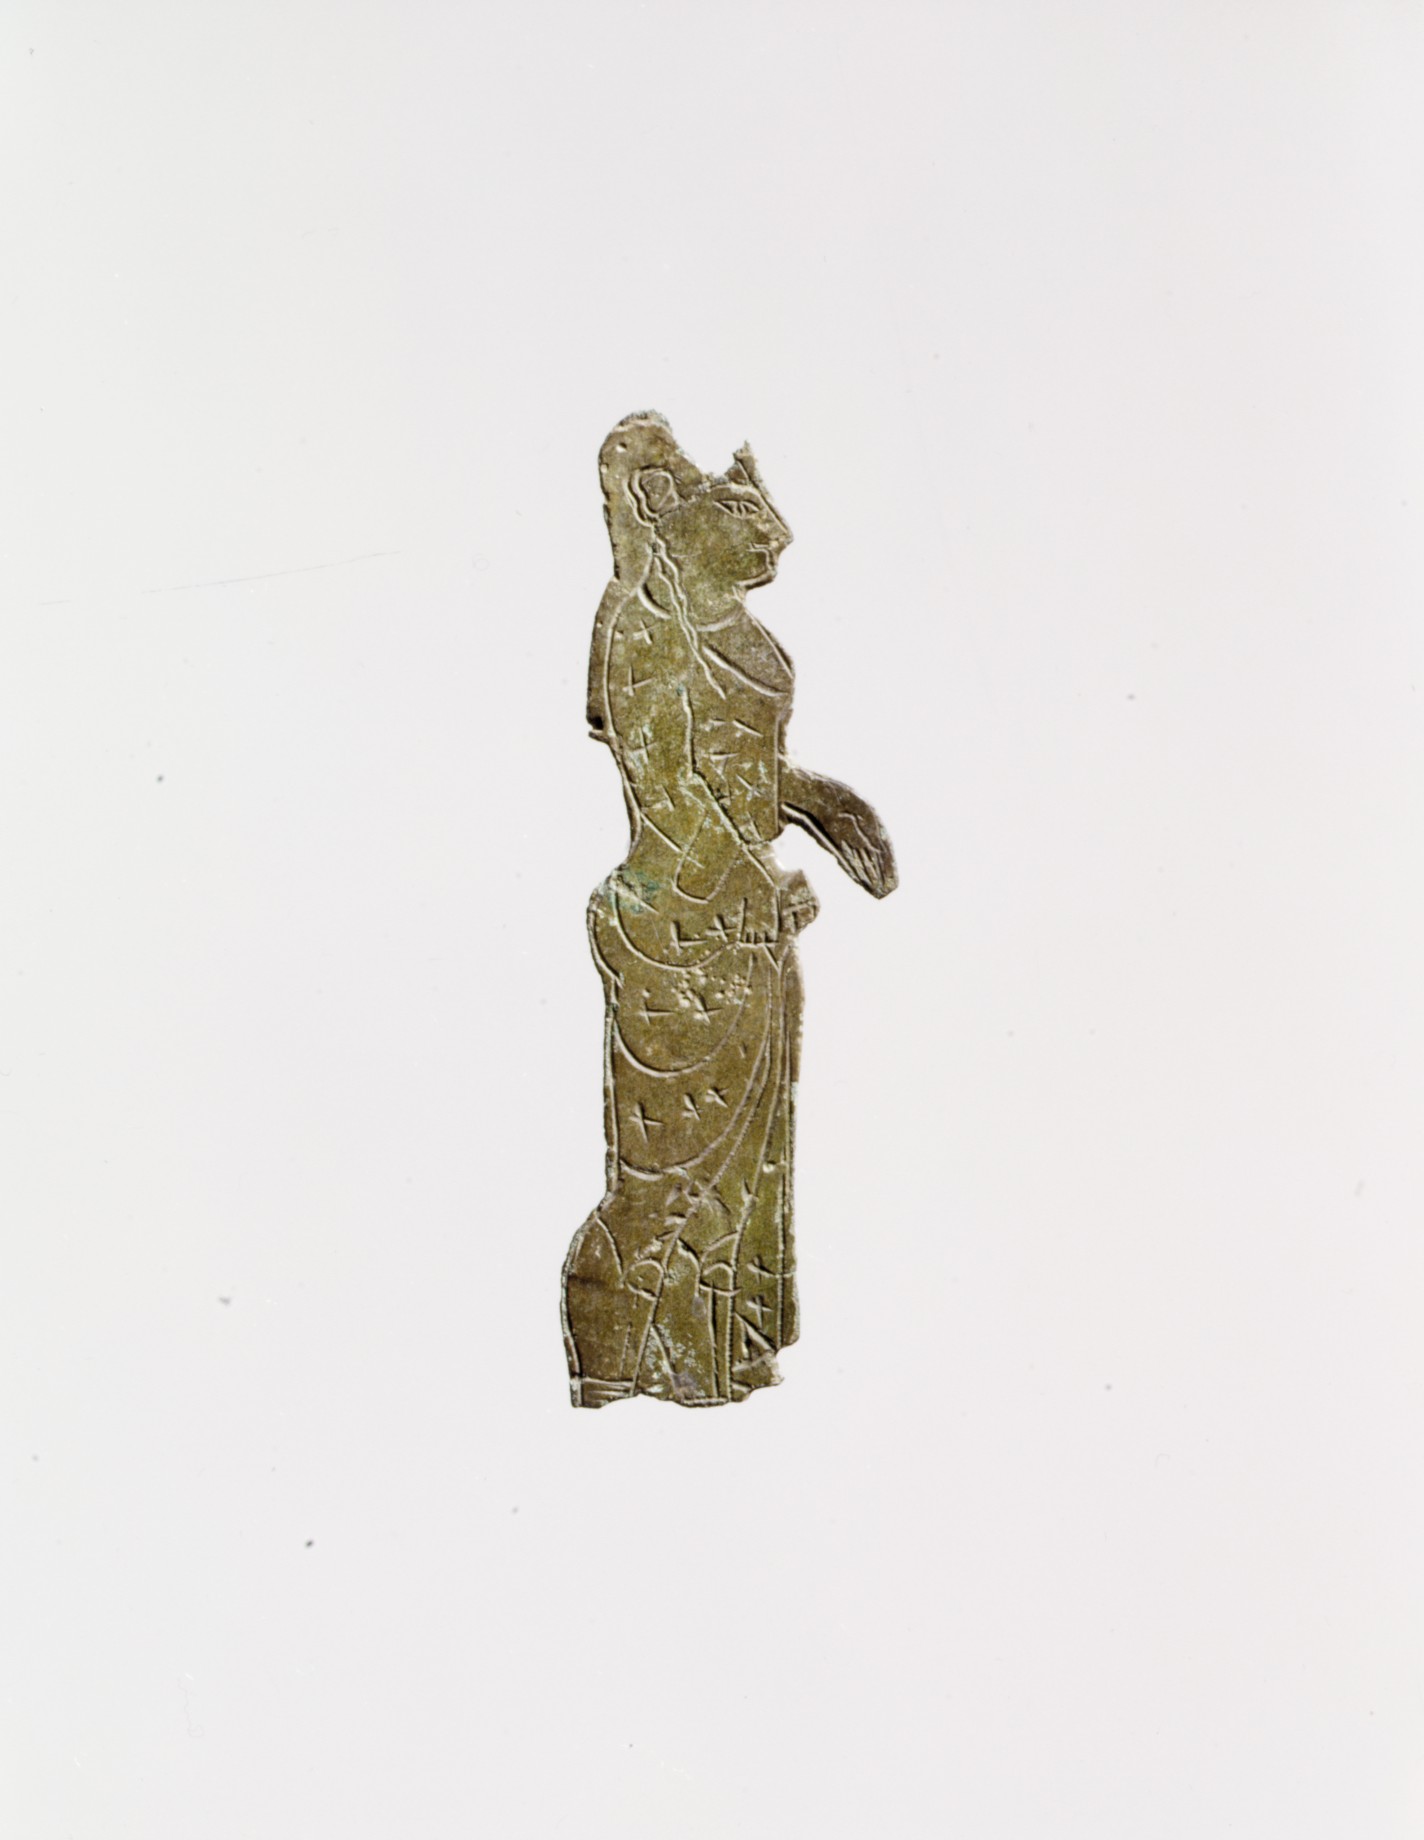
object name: plaque of a woman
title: Bronze plaque of a woman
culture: etruscan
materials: bronze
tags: women